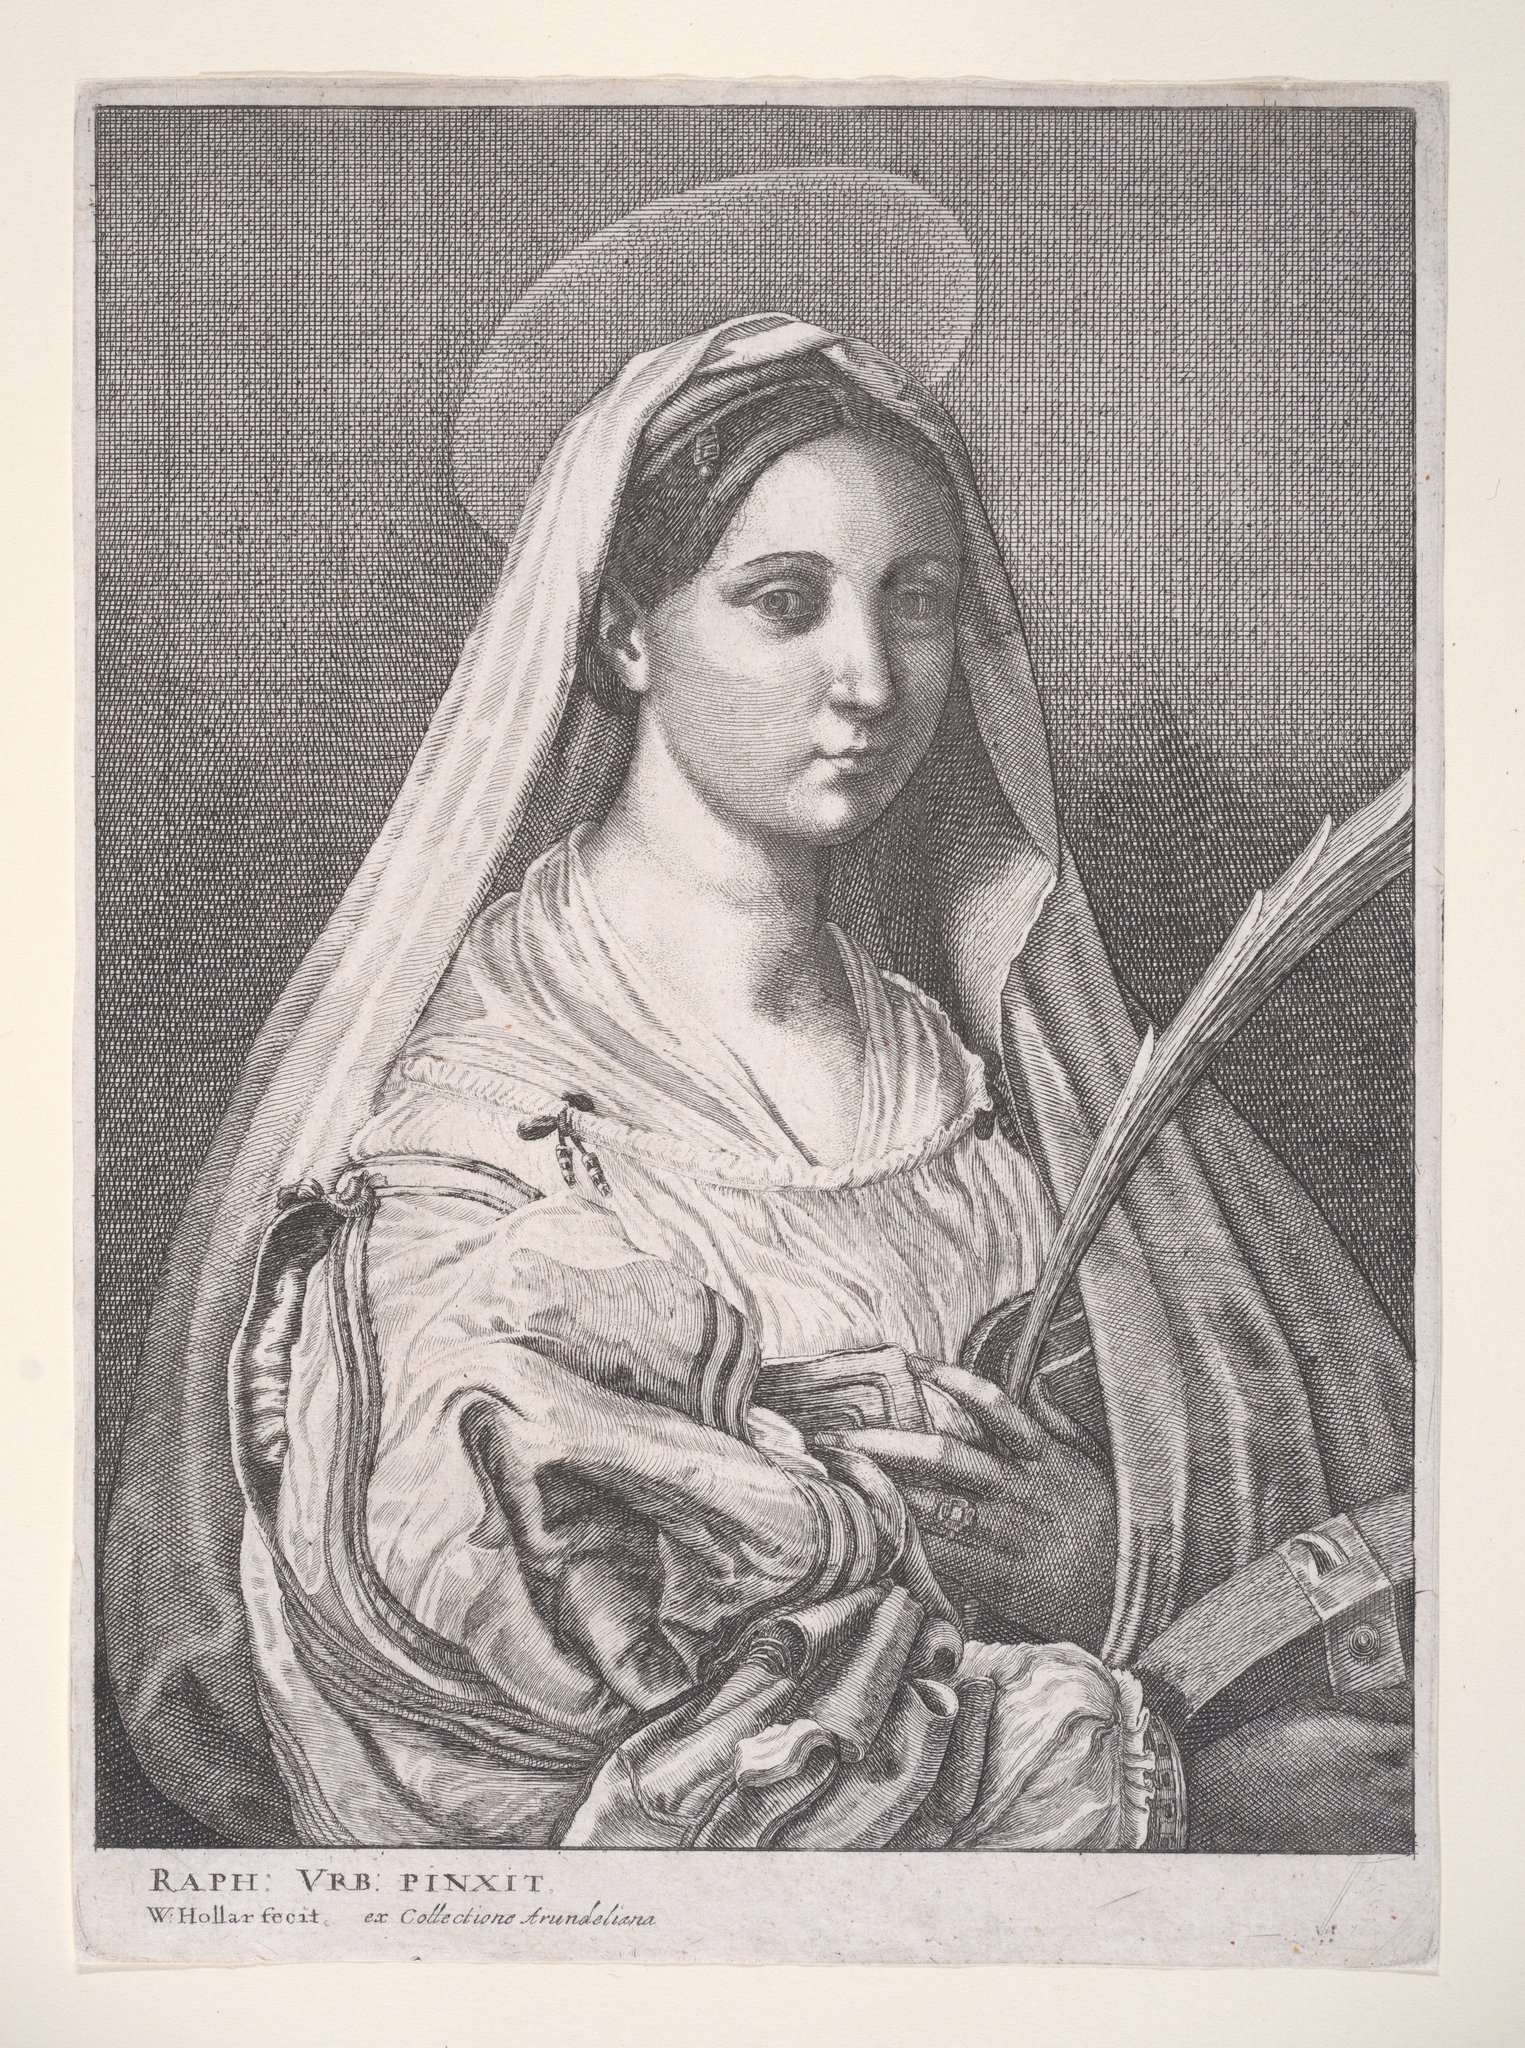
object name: print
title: St. Catherine of Alexandria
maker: wenceslaus hollar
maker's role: artist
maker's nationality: bohemian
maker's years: 1607-1677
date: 1644-1650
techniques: engraving, etching